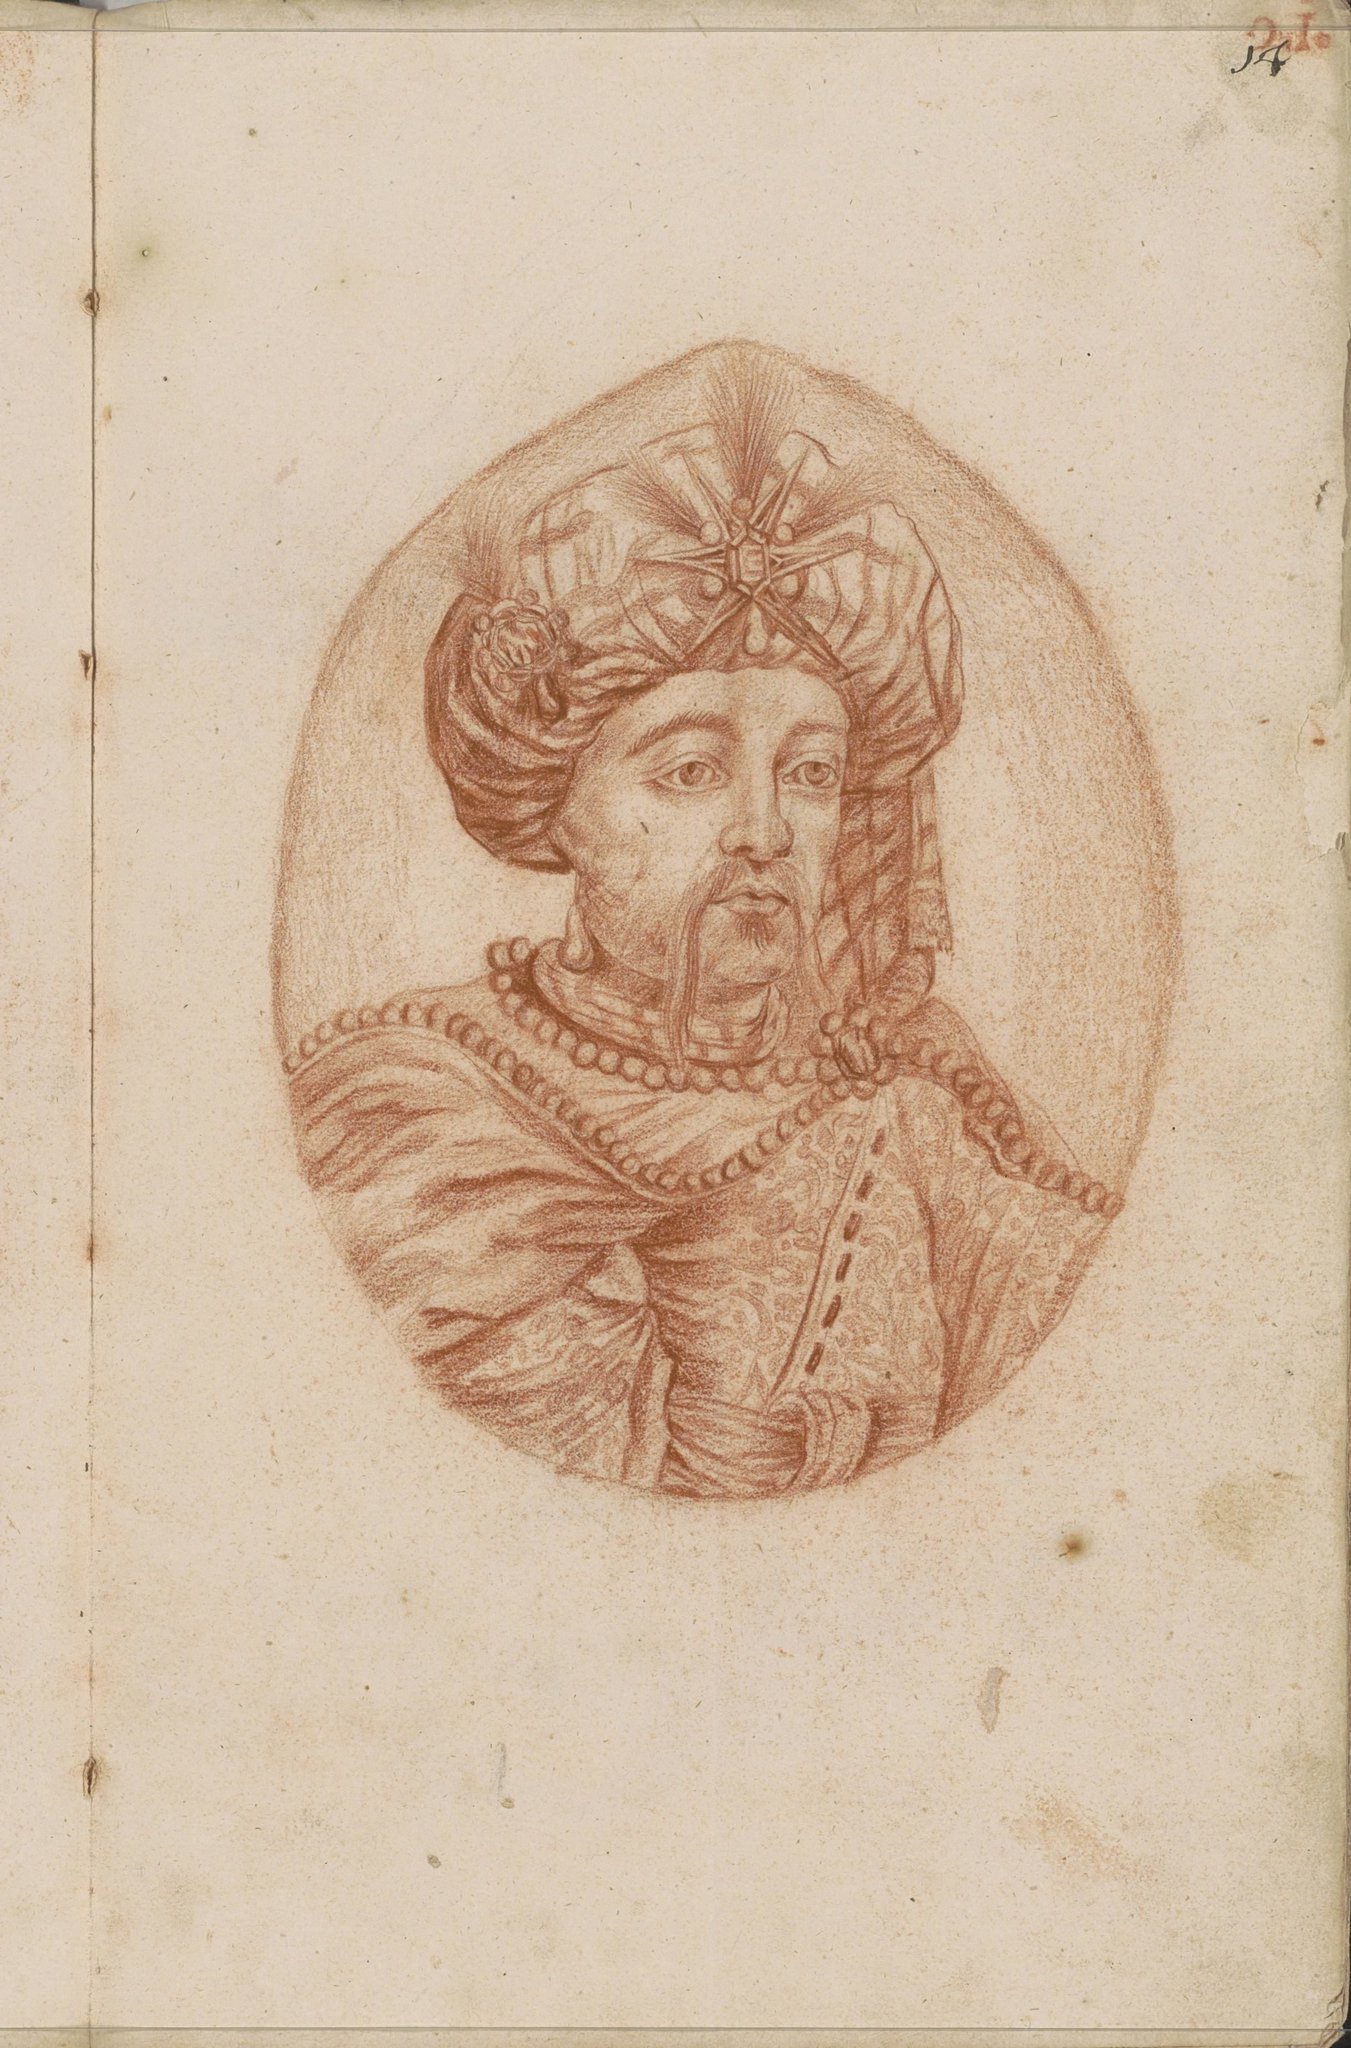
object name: sketchbook leaf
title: Portret van een man in oosters kostuum met tulband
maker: hendrick van beaumont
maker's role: draughtsman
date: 1696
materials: chalk, paper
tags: head-gear: turban, anonymous historical person portrayed, folk costume, regional costume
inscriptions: number: ‘21’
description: De man heeft een lange snor en draagt rijk versierde kleding. Portret in een ovaal. Blad 16 recto uit een schetsboek met 30 bladen.